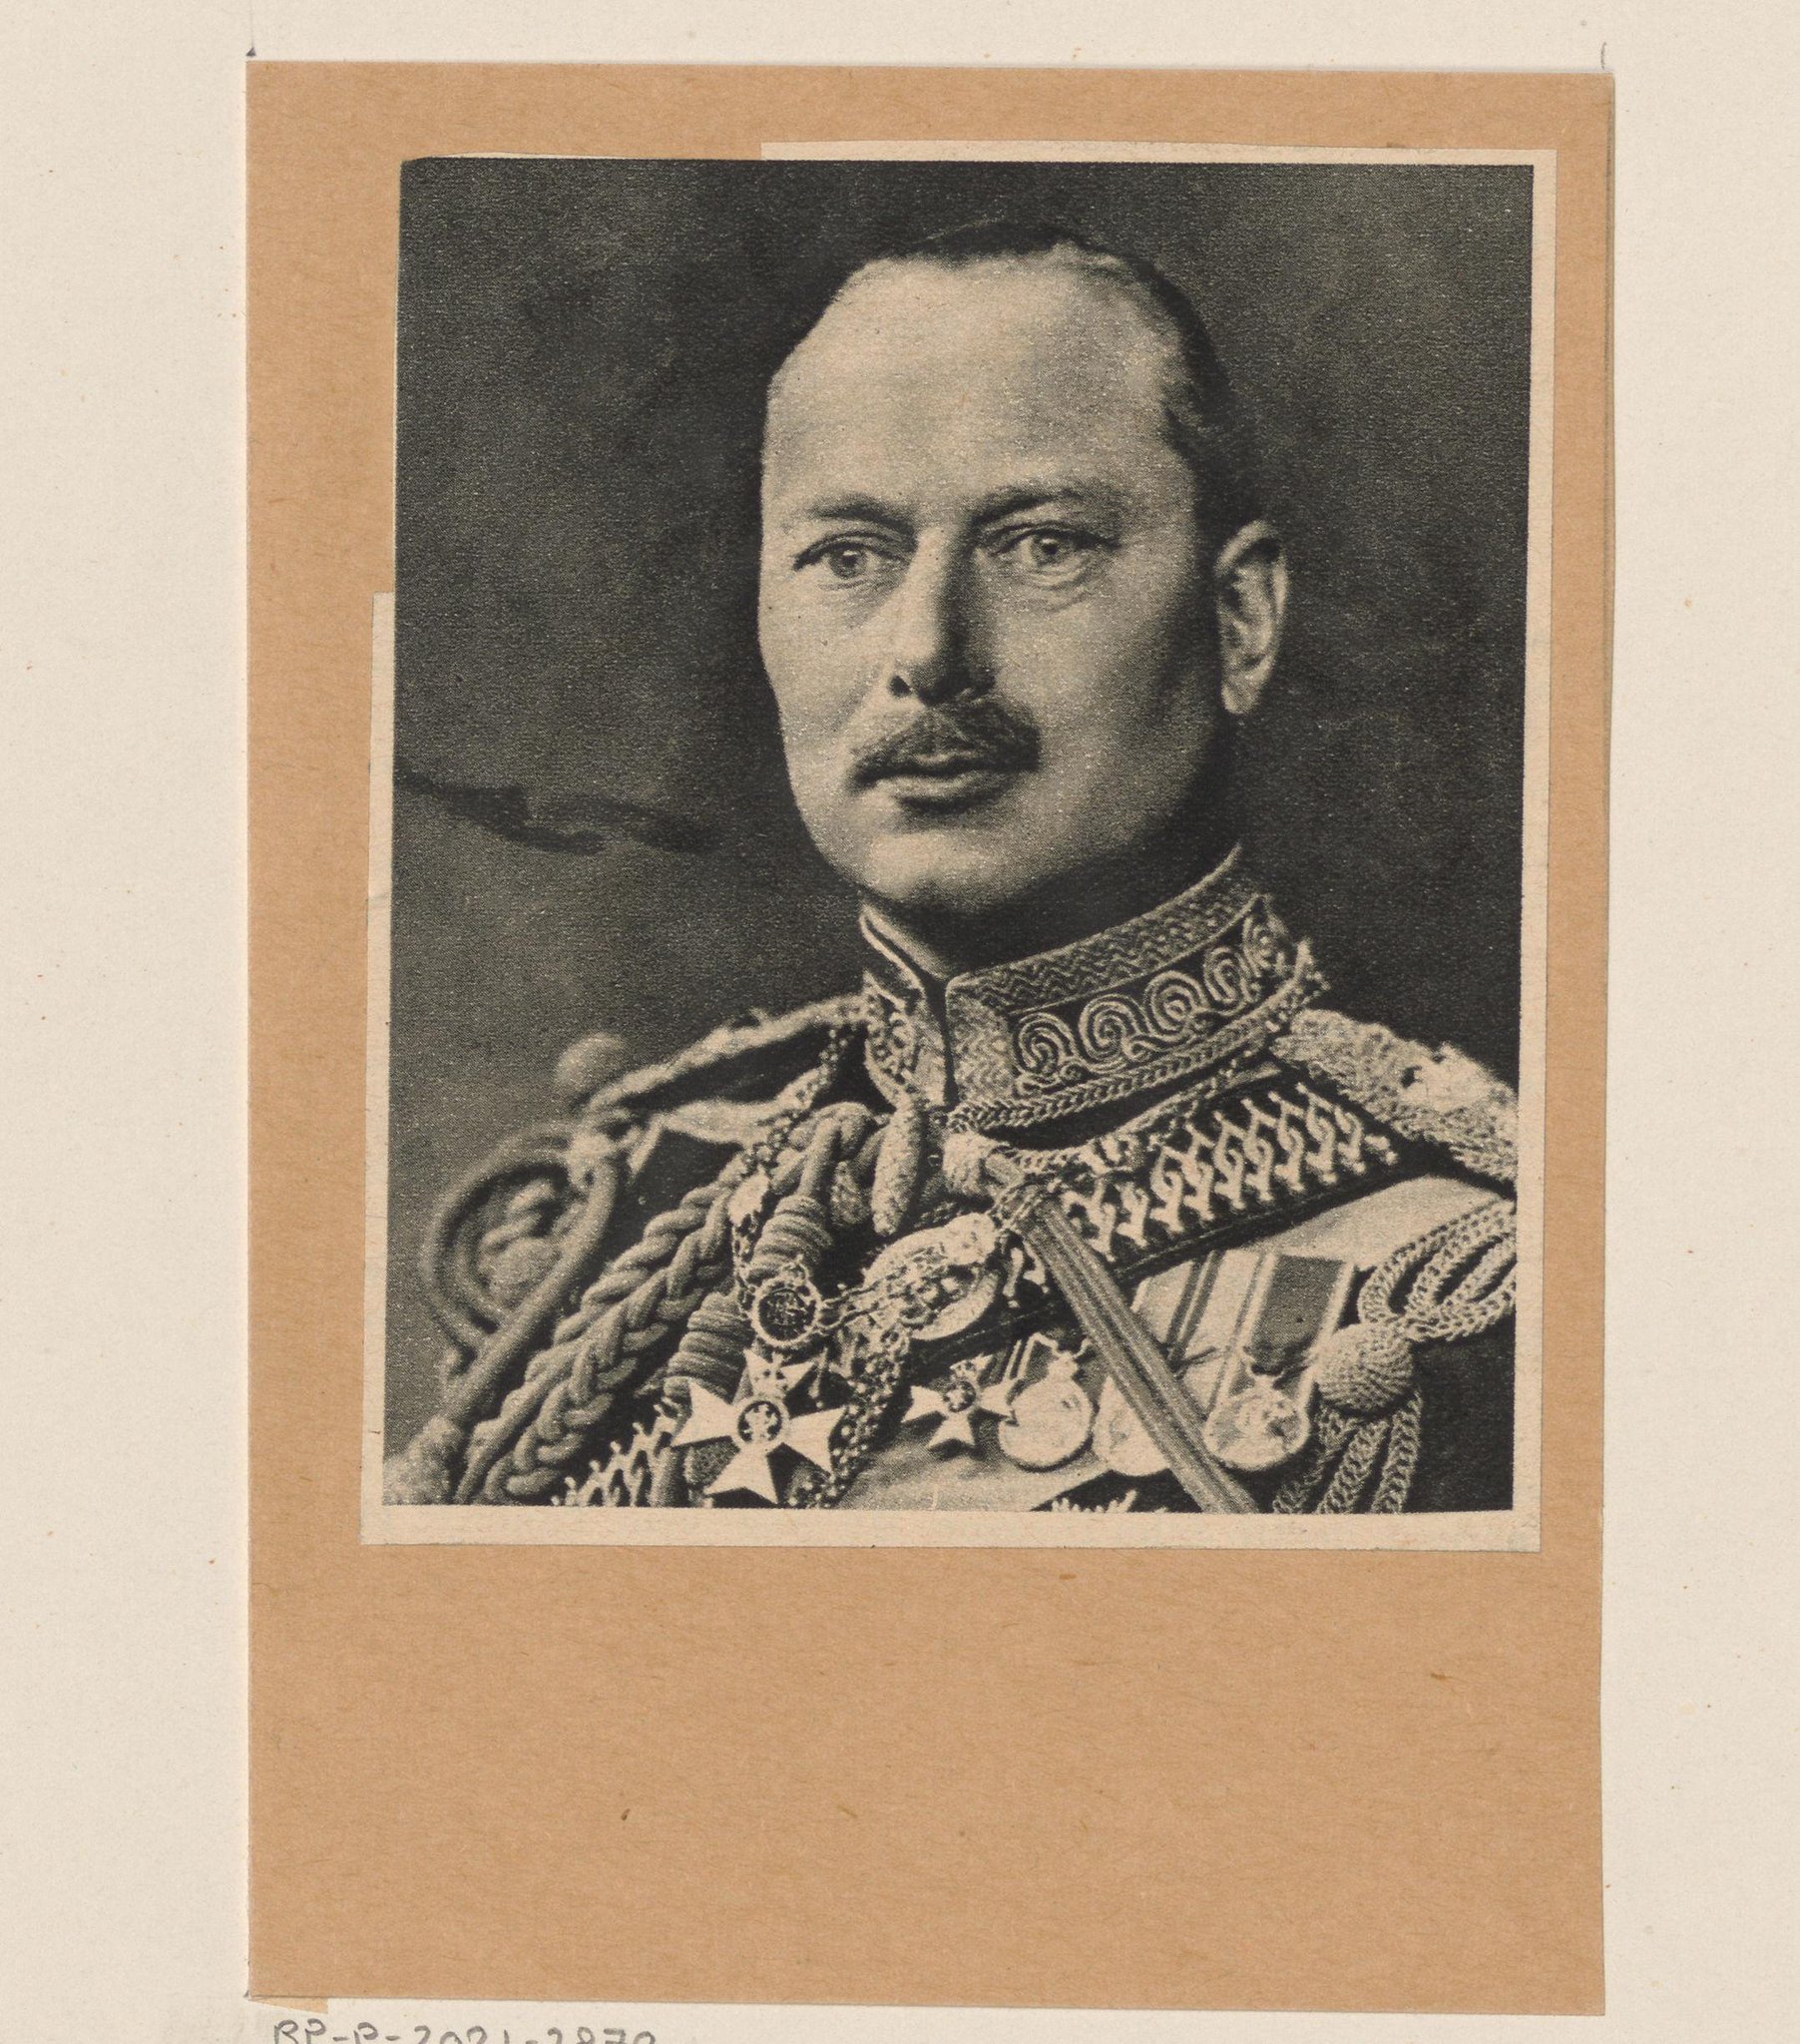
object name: photomechanical print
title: Portret van Hendrik Willem Frederik Albert, hertog van Gloucester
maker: Anonymous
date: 1930-1960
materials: paper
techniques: rotogravure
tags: historical persons